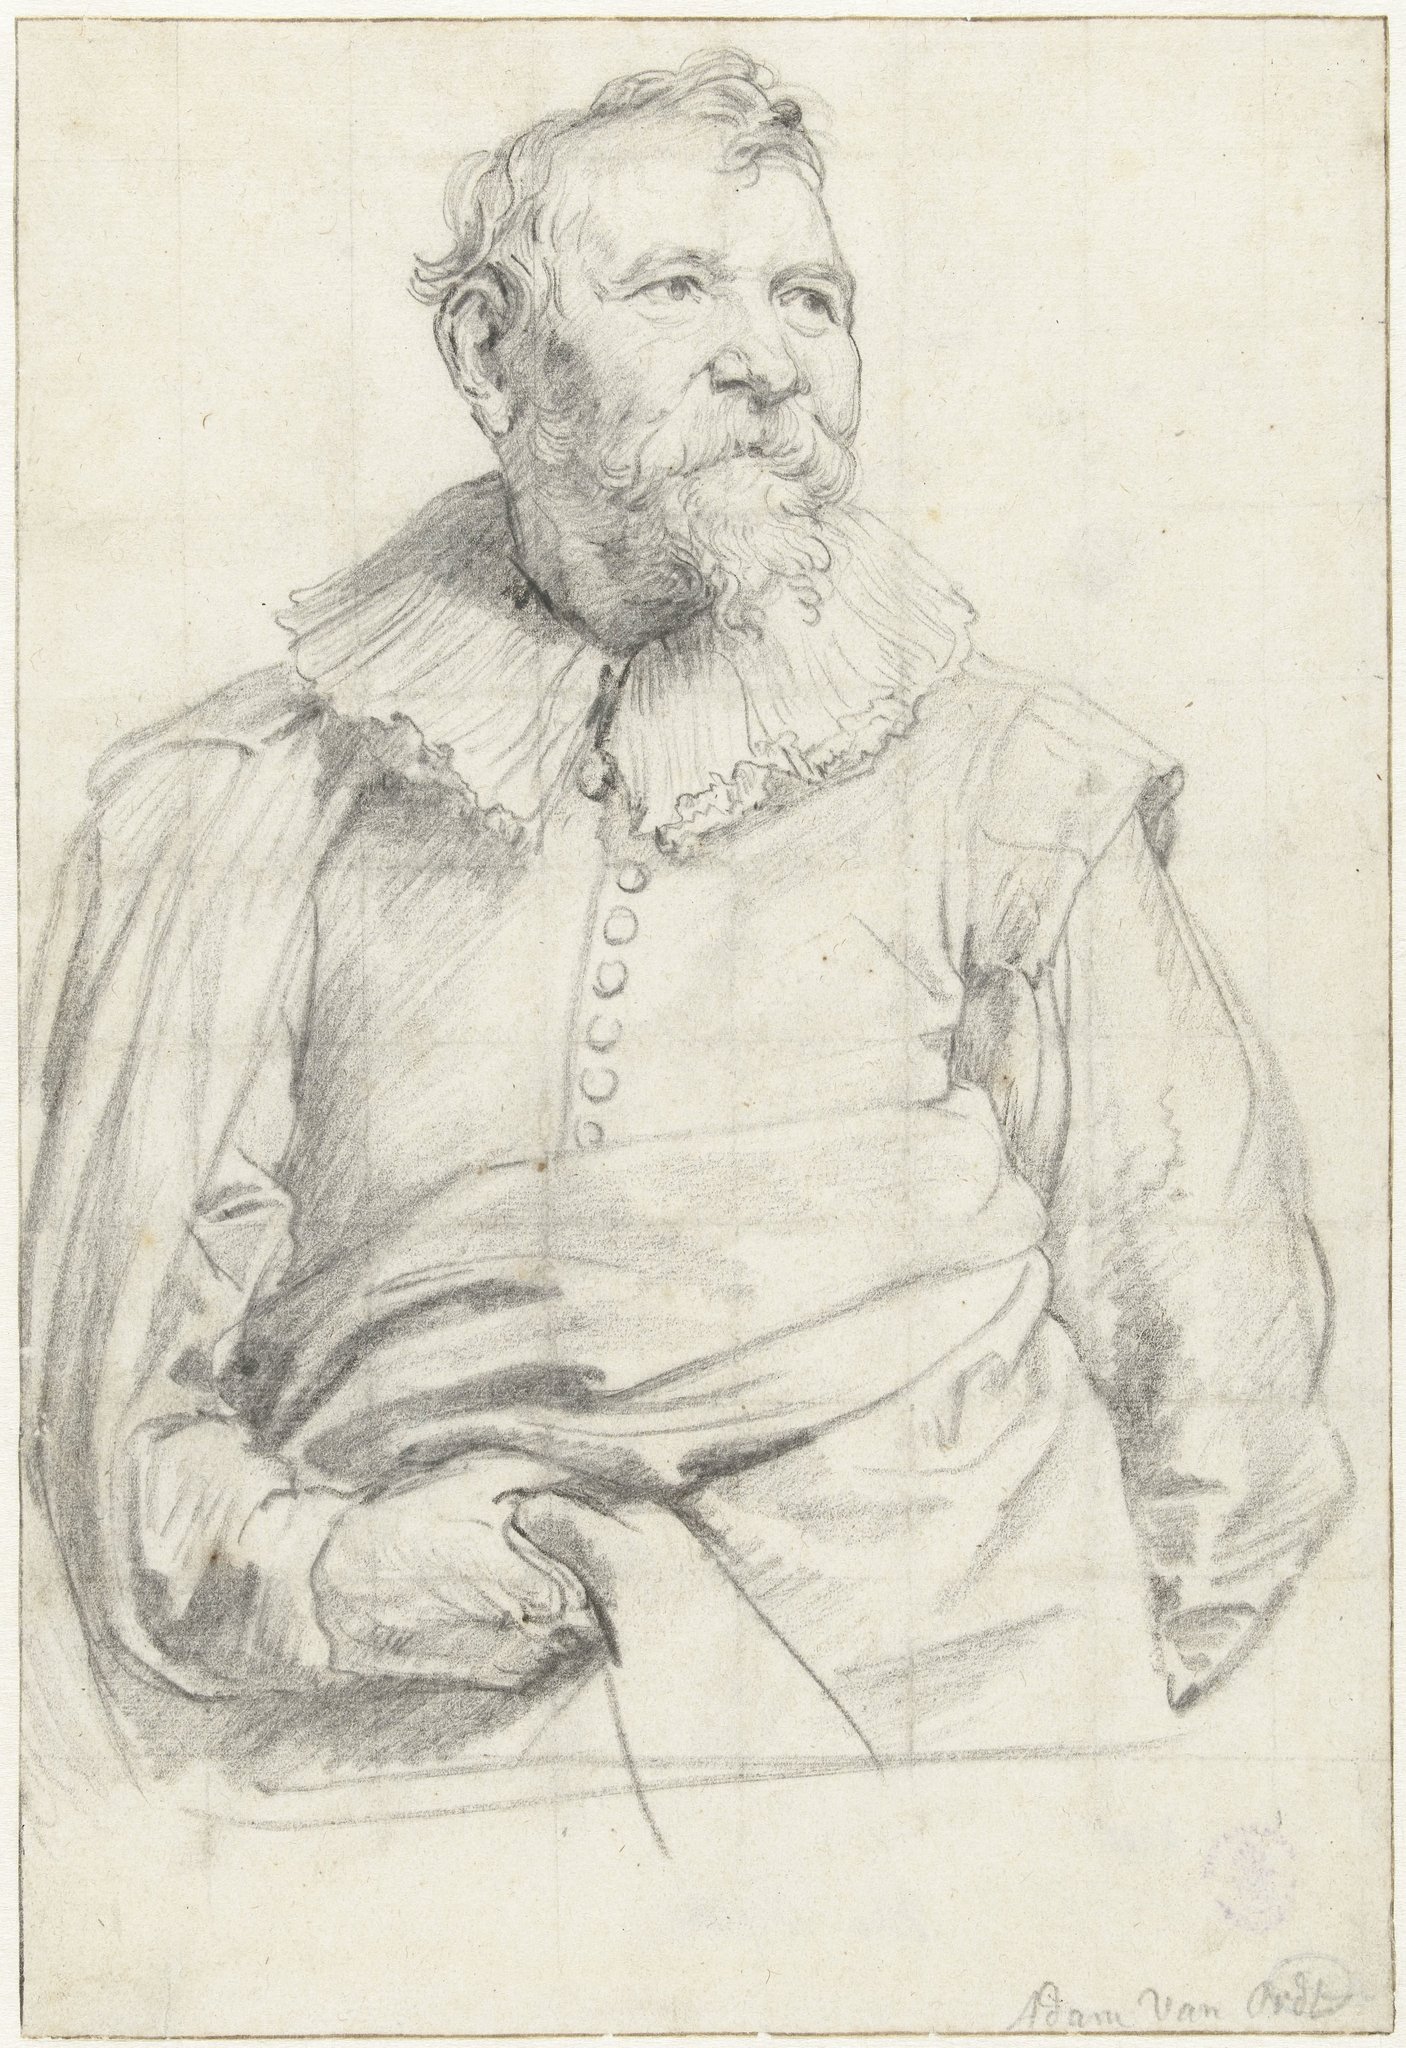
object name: design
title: Portret van de schilder Adam van Noort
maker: anthony van dyck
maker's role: draughtsman, painter, print maker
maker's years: 1599-1641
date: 1627-1635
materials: chalk, paper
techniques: drawing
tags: antwerp, painter, draughtsman, adam van noort, historical persons, portrait, self-portrait of painter